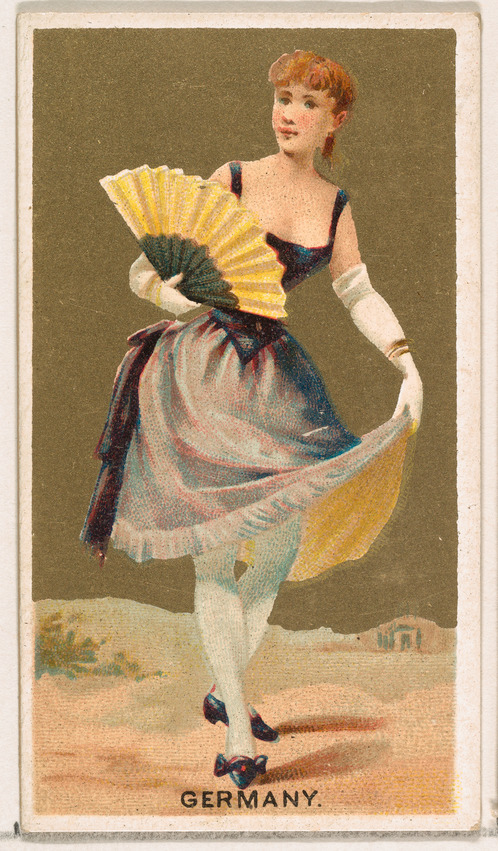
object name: print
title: Germany, from the Dancing Girls of the World series (N185) issued by Wm. S. Kimball & Co.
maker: william s. kimball & company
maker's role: publisher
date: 1889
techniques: color lithograph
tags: women,dancing,actresses